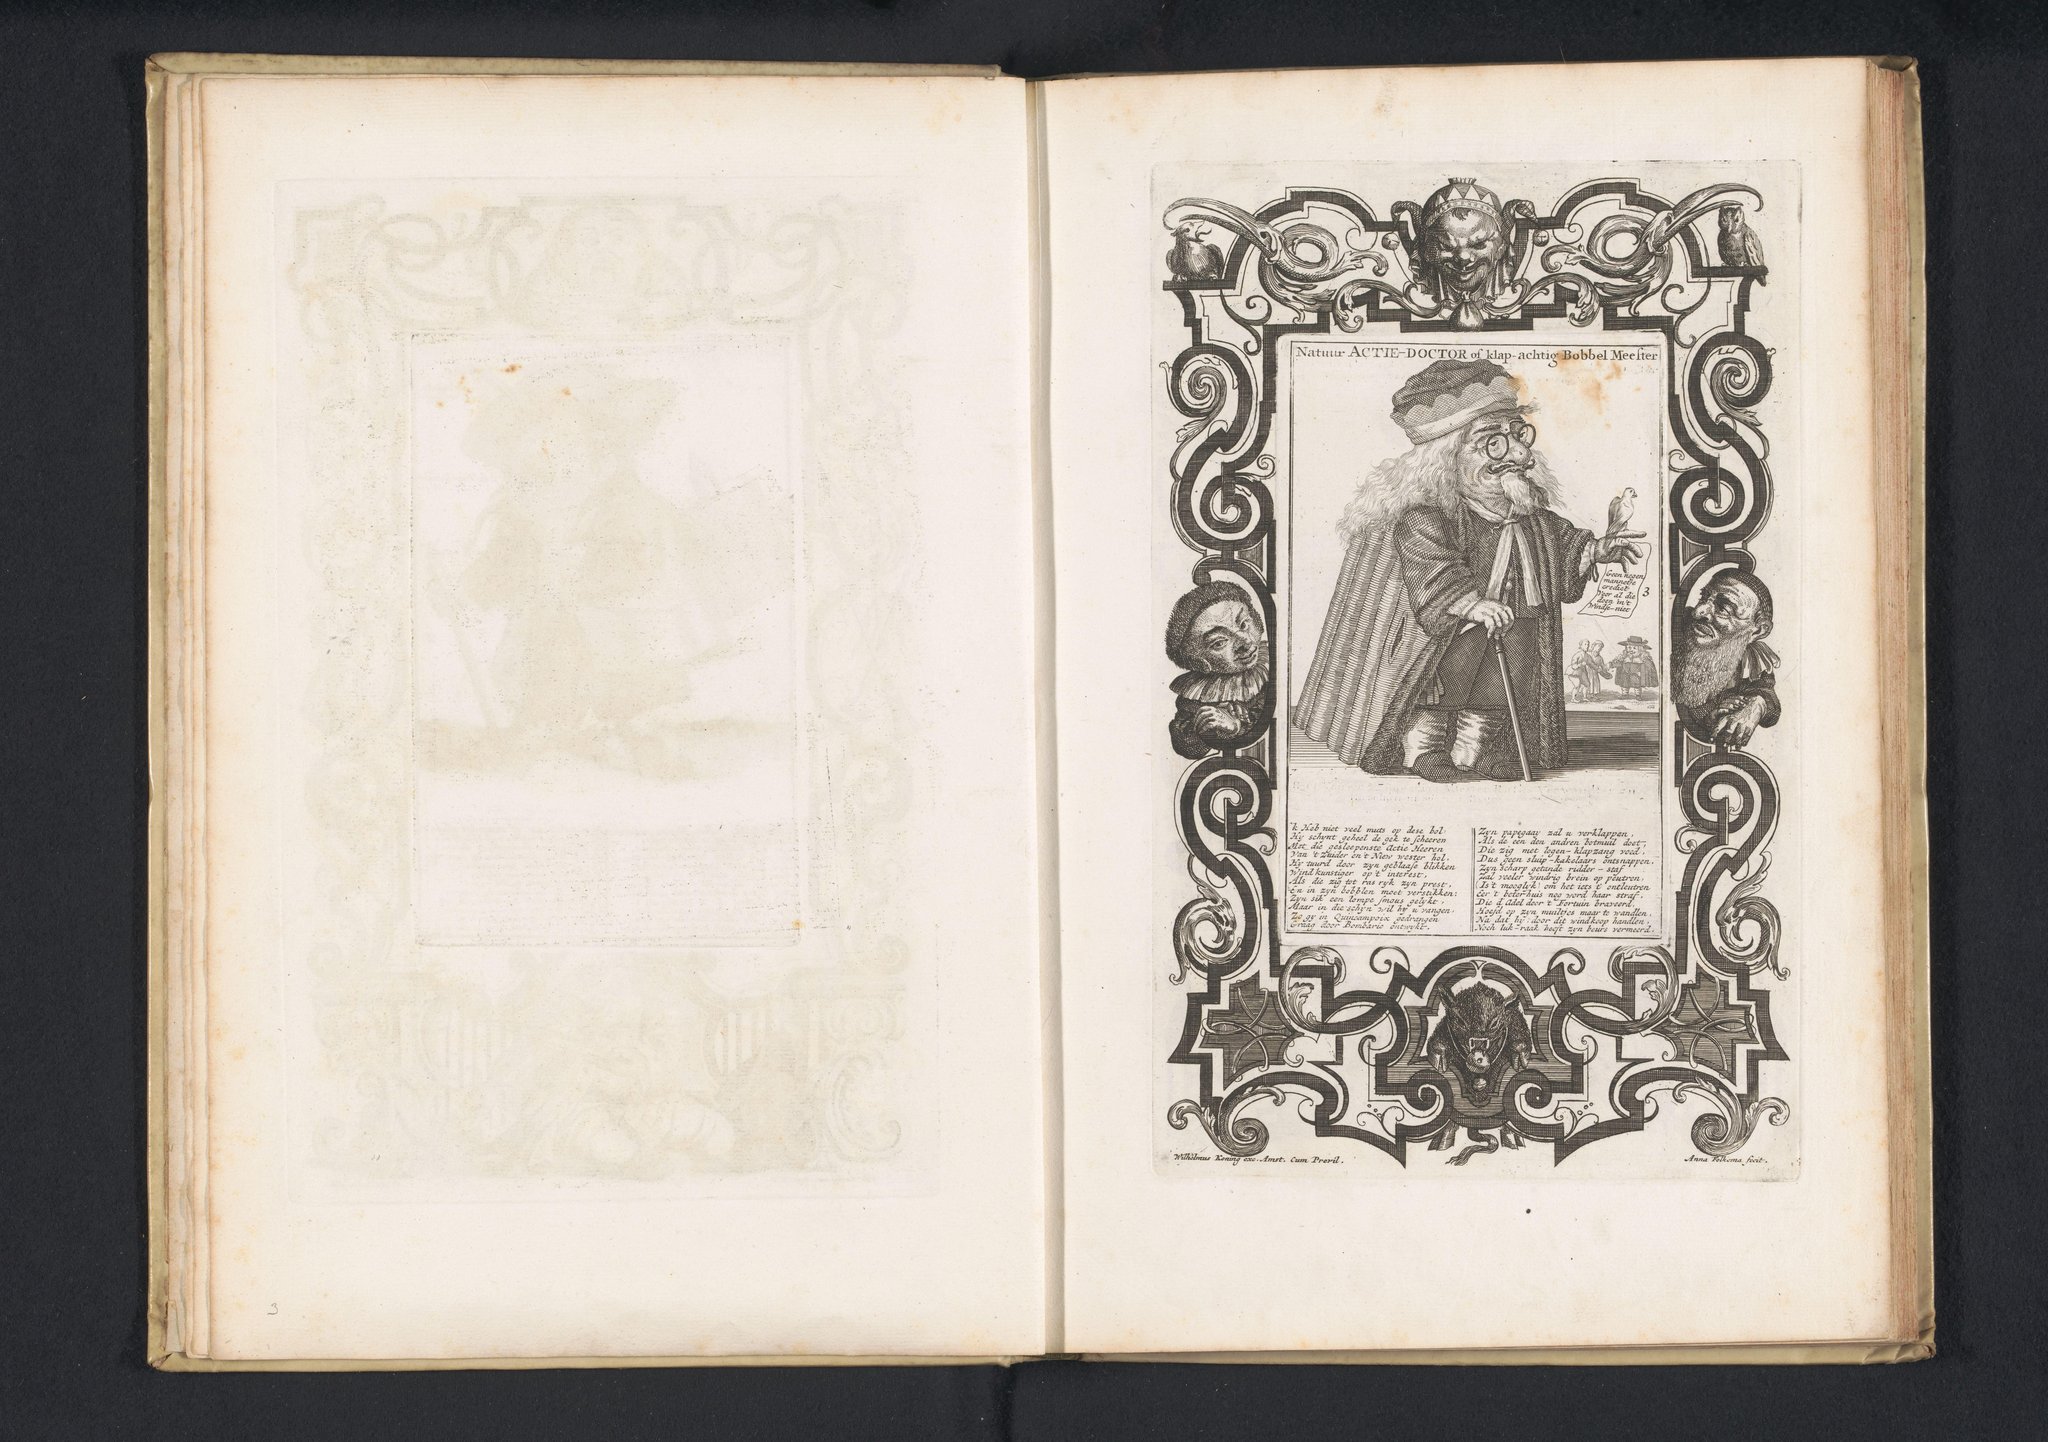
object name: print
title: Bombario Actionist en de Geest van Esopus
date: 1716-1720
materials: paper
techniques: etching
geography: northern netherlands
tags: caricatures (human types), little people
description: Een kleine mens als arts met een vogel op zijn hand. In het onderschrift een vers in twee kolommen in het Nederlands. Genummerd rechts midden: 3. Afdruk binnen een decoratieve omlijsting gedrukt van een aparte plaat met kleine mensen en dieren. Onderdeel van de tweede Nederlandse gebonden uitgave uit 1720 (en gerelateerd aan de Windhandel in dat jaar) van een serie karikaturen van kleine mensen, bekend als Het Dwergentooneel, deels gekopieerd naar een ouder Duits voorbeeld.